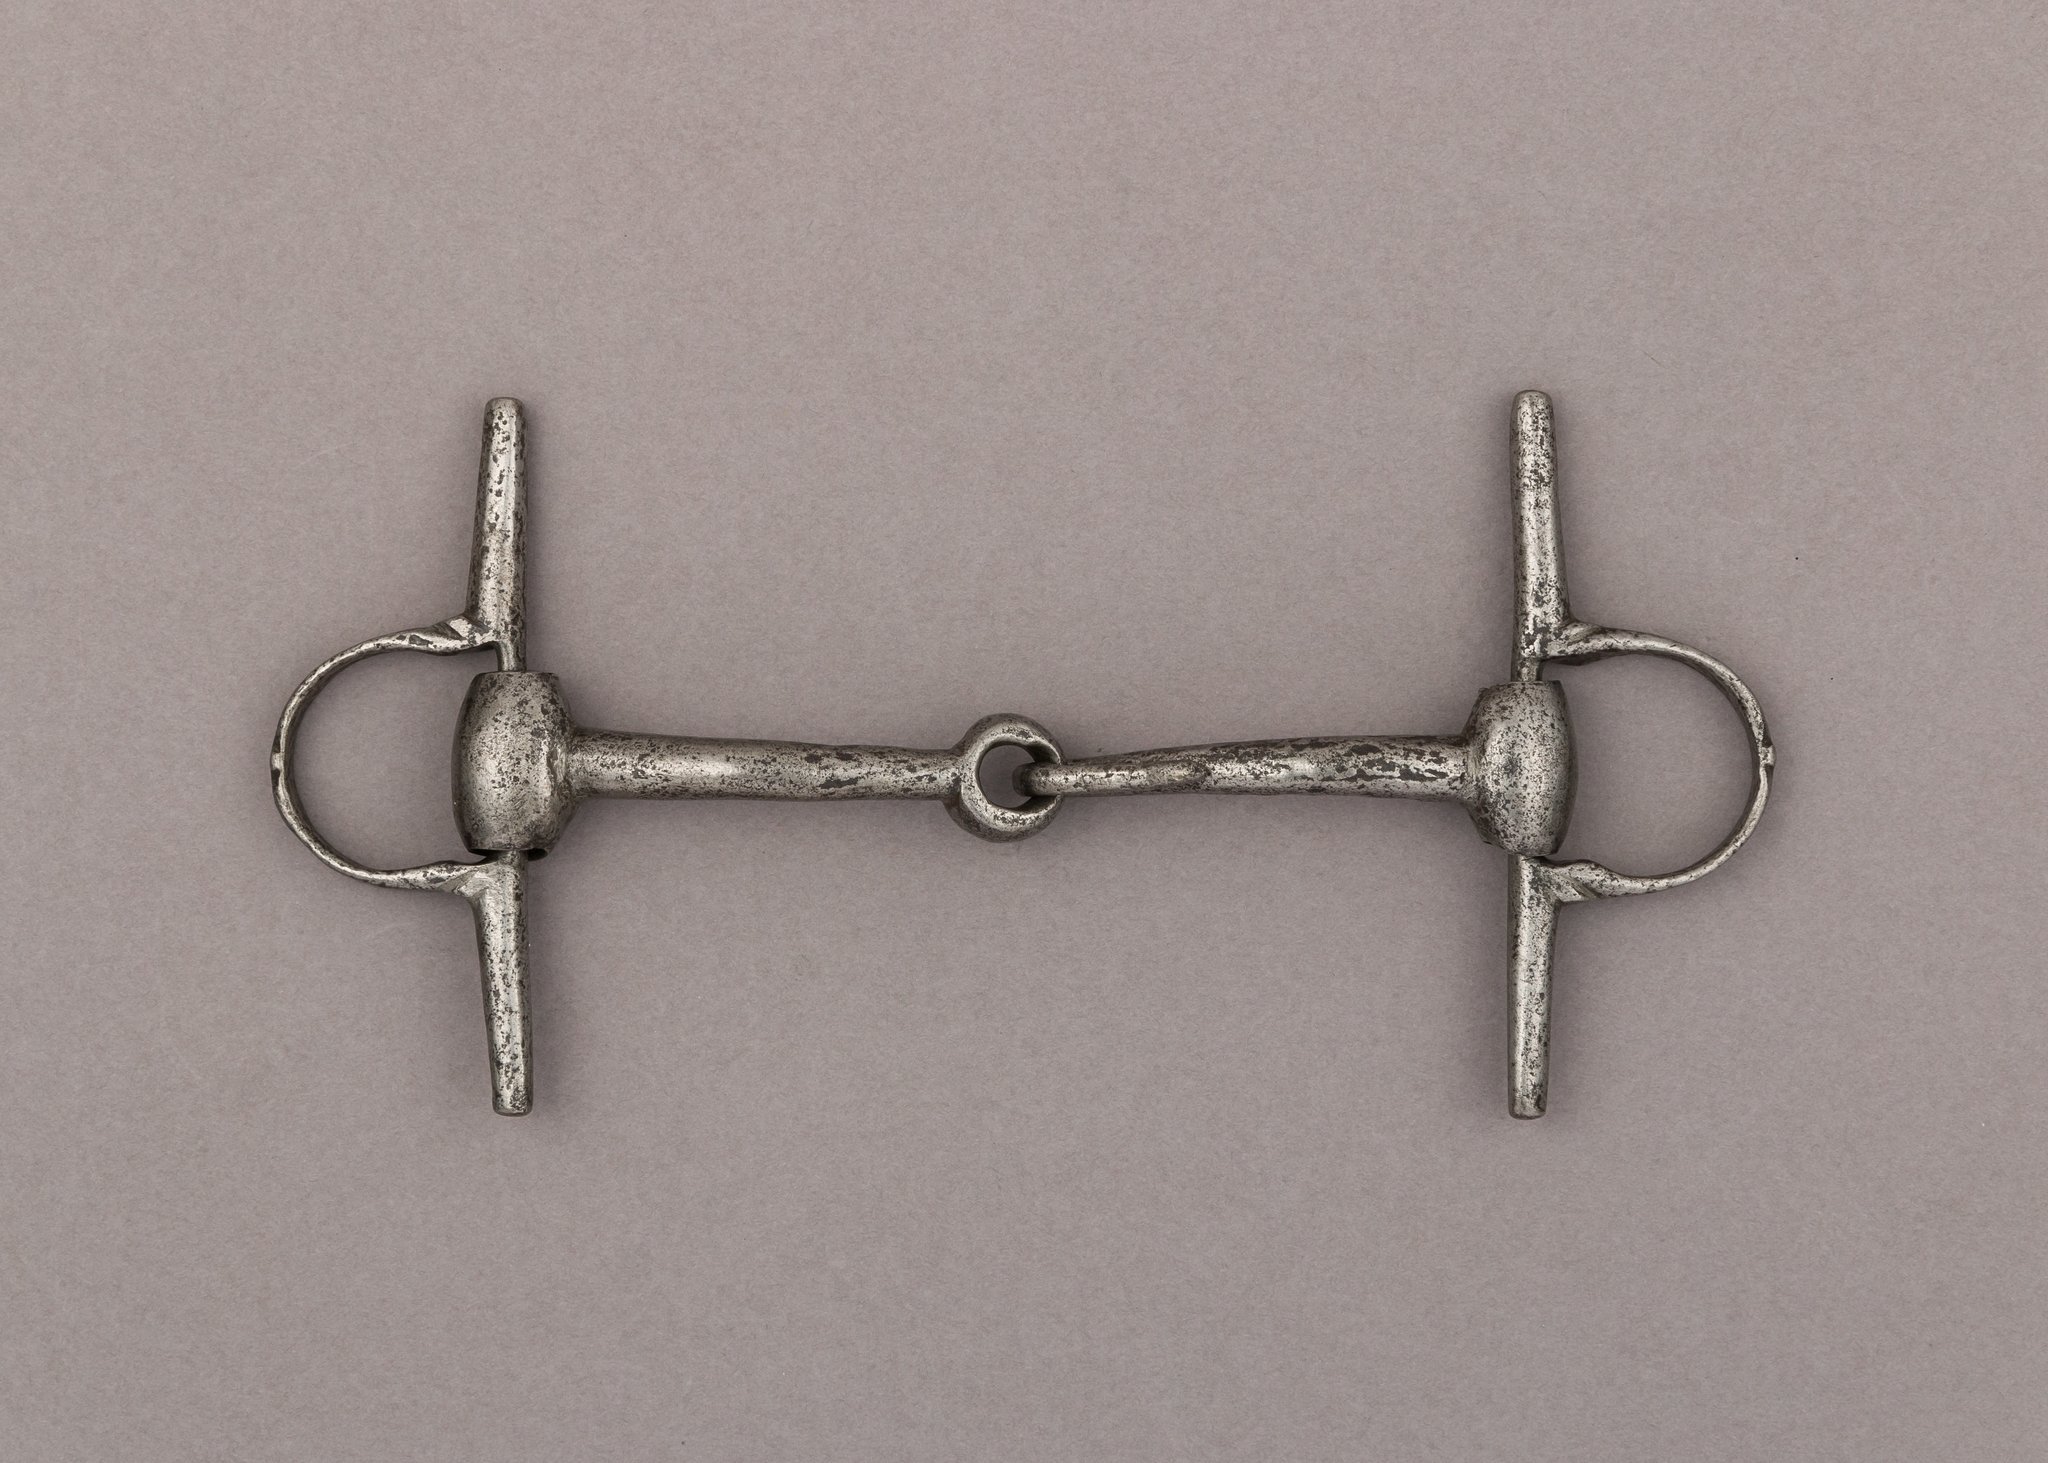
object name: bit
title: Snaffle Bit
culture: german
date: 1567-1633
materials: metal alloy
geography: germany